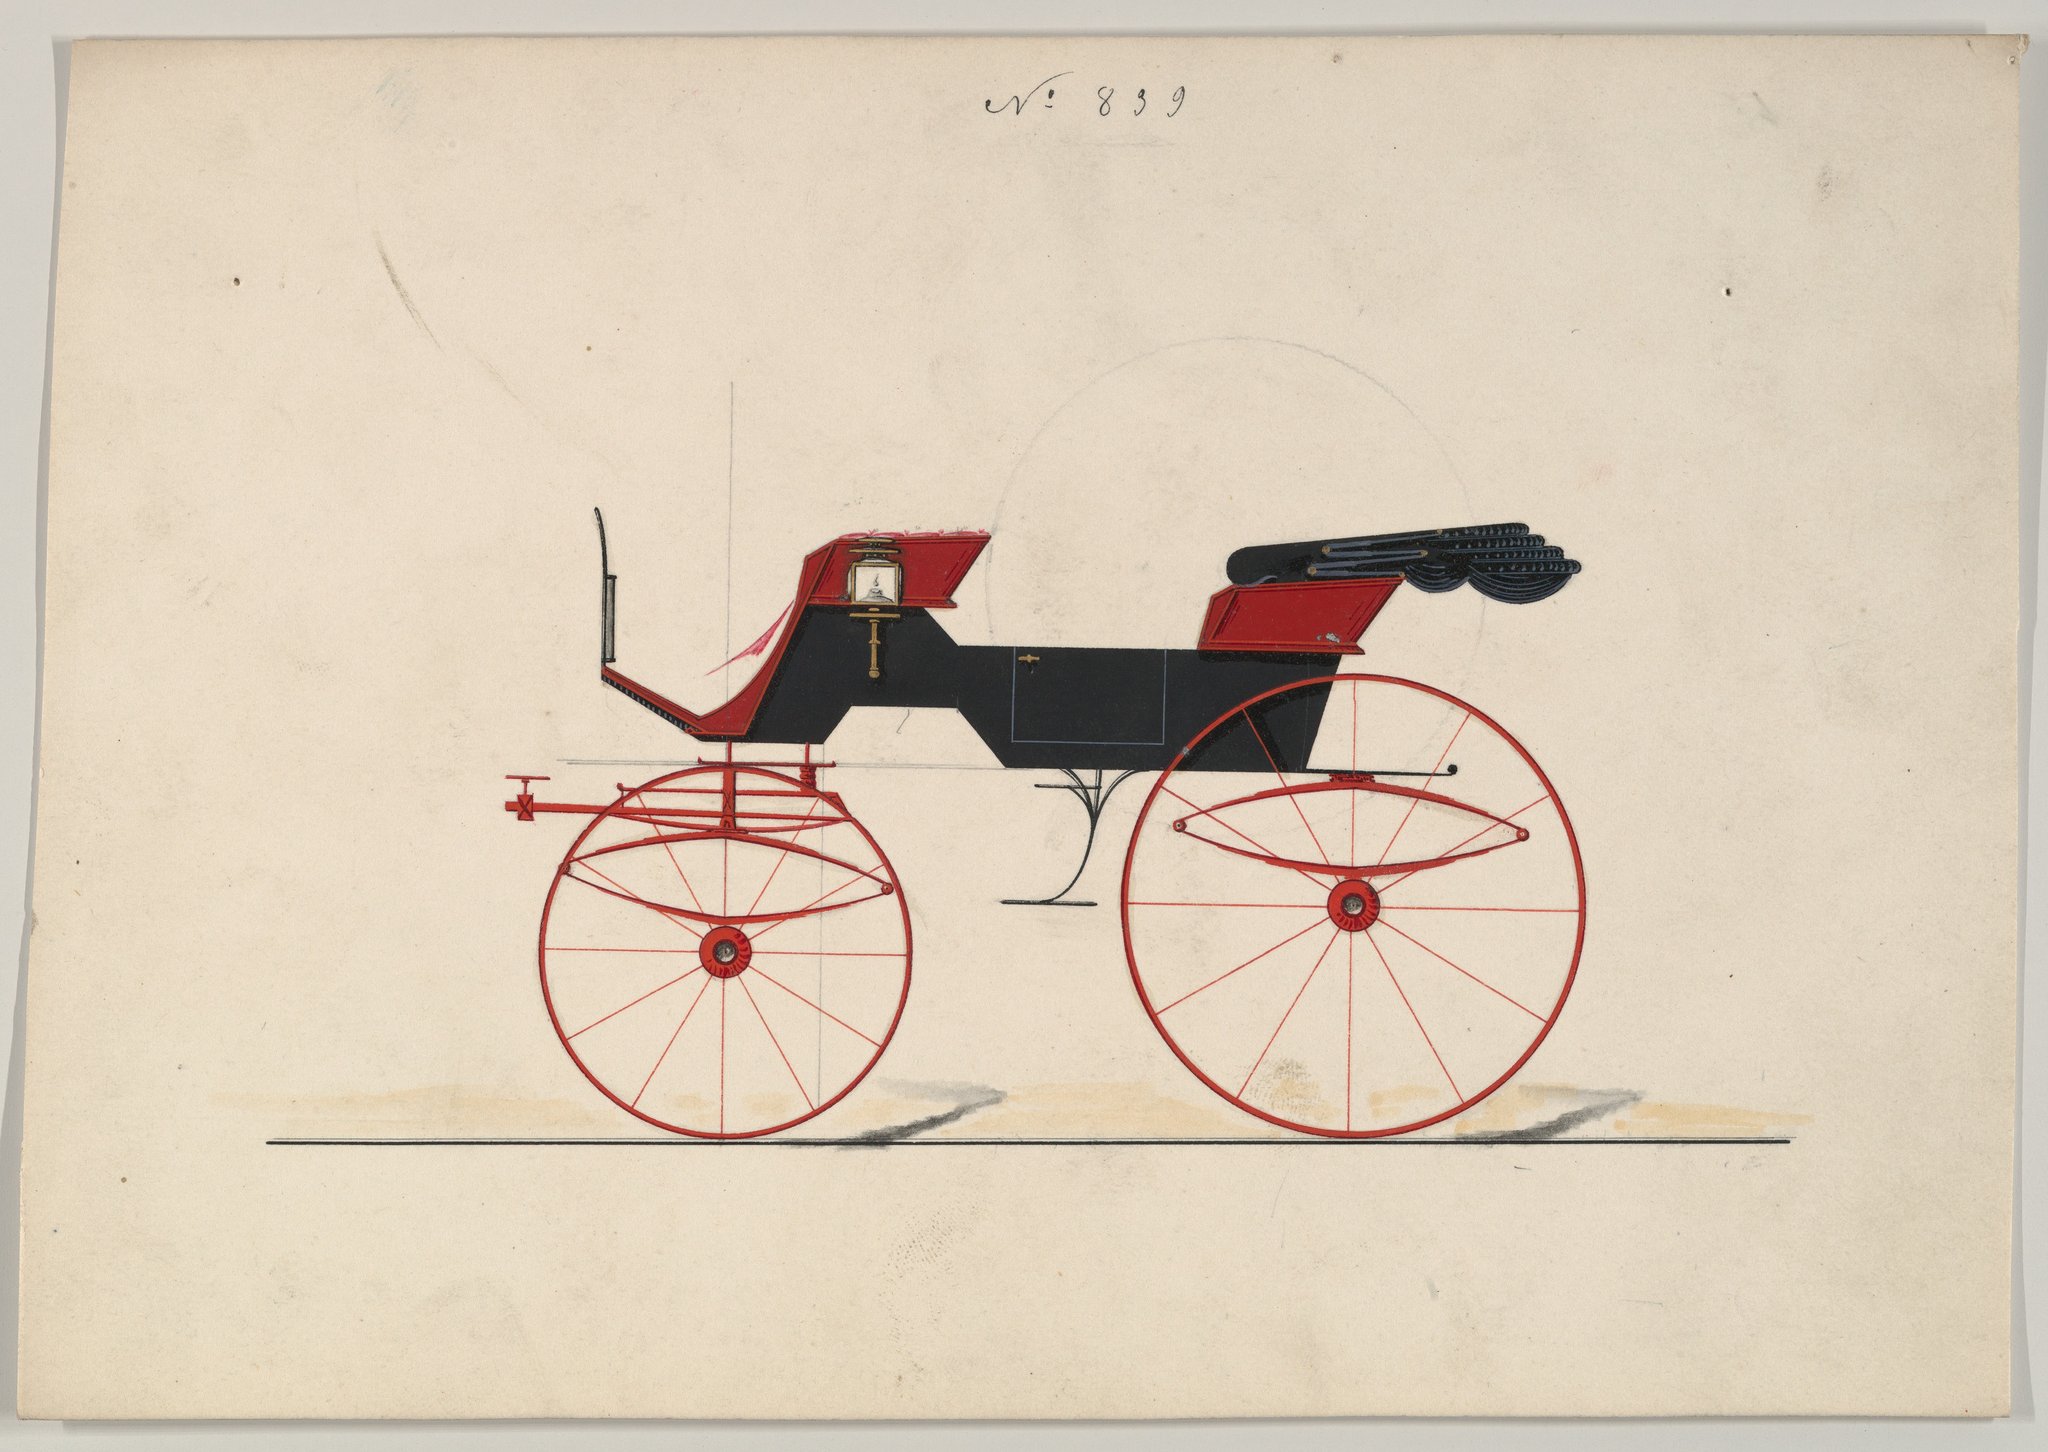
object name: drawing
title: Design for Phaeton, no. 839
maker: brewster & co.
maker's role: manufacturer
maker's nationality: american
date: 1850-1874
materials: gouache, graphite, gum arabic, ink, watercolor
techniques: pen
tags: carriages